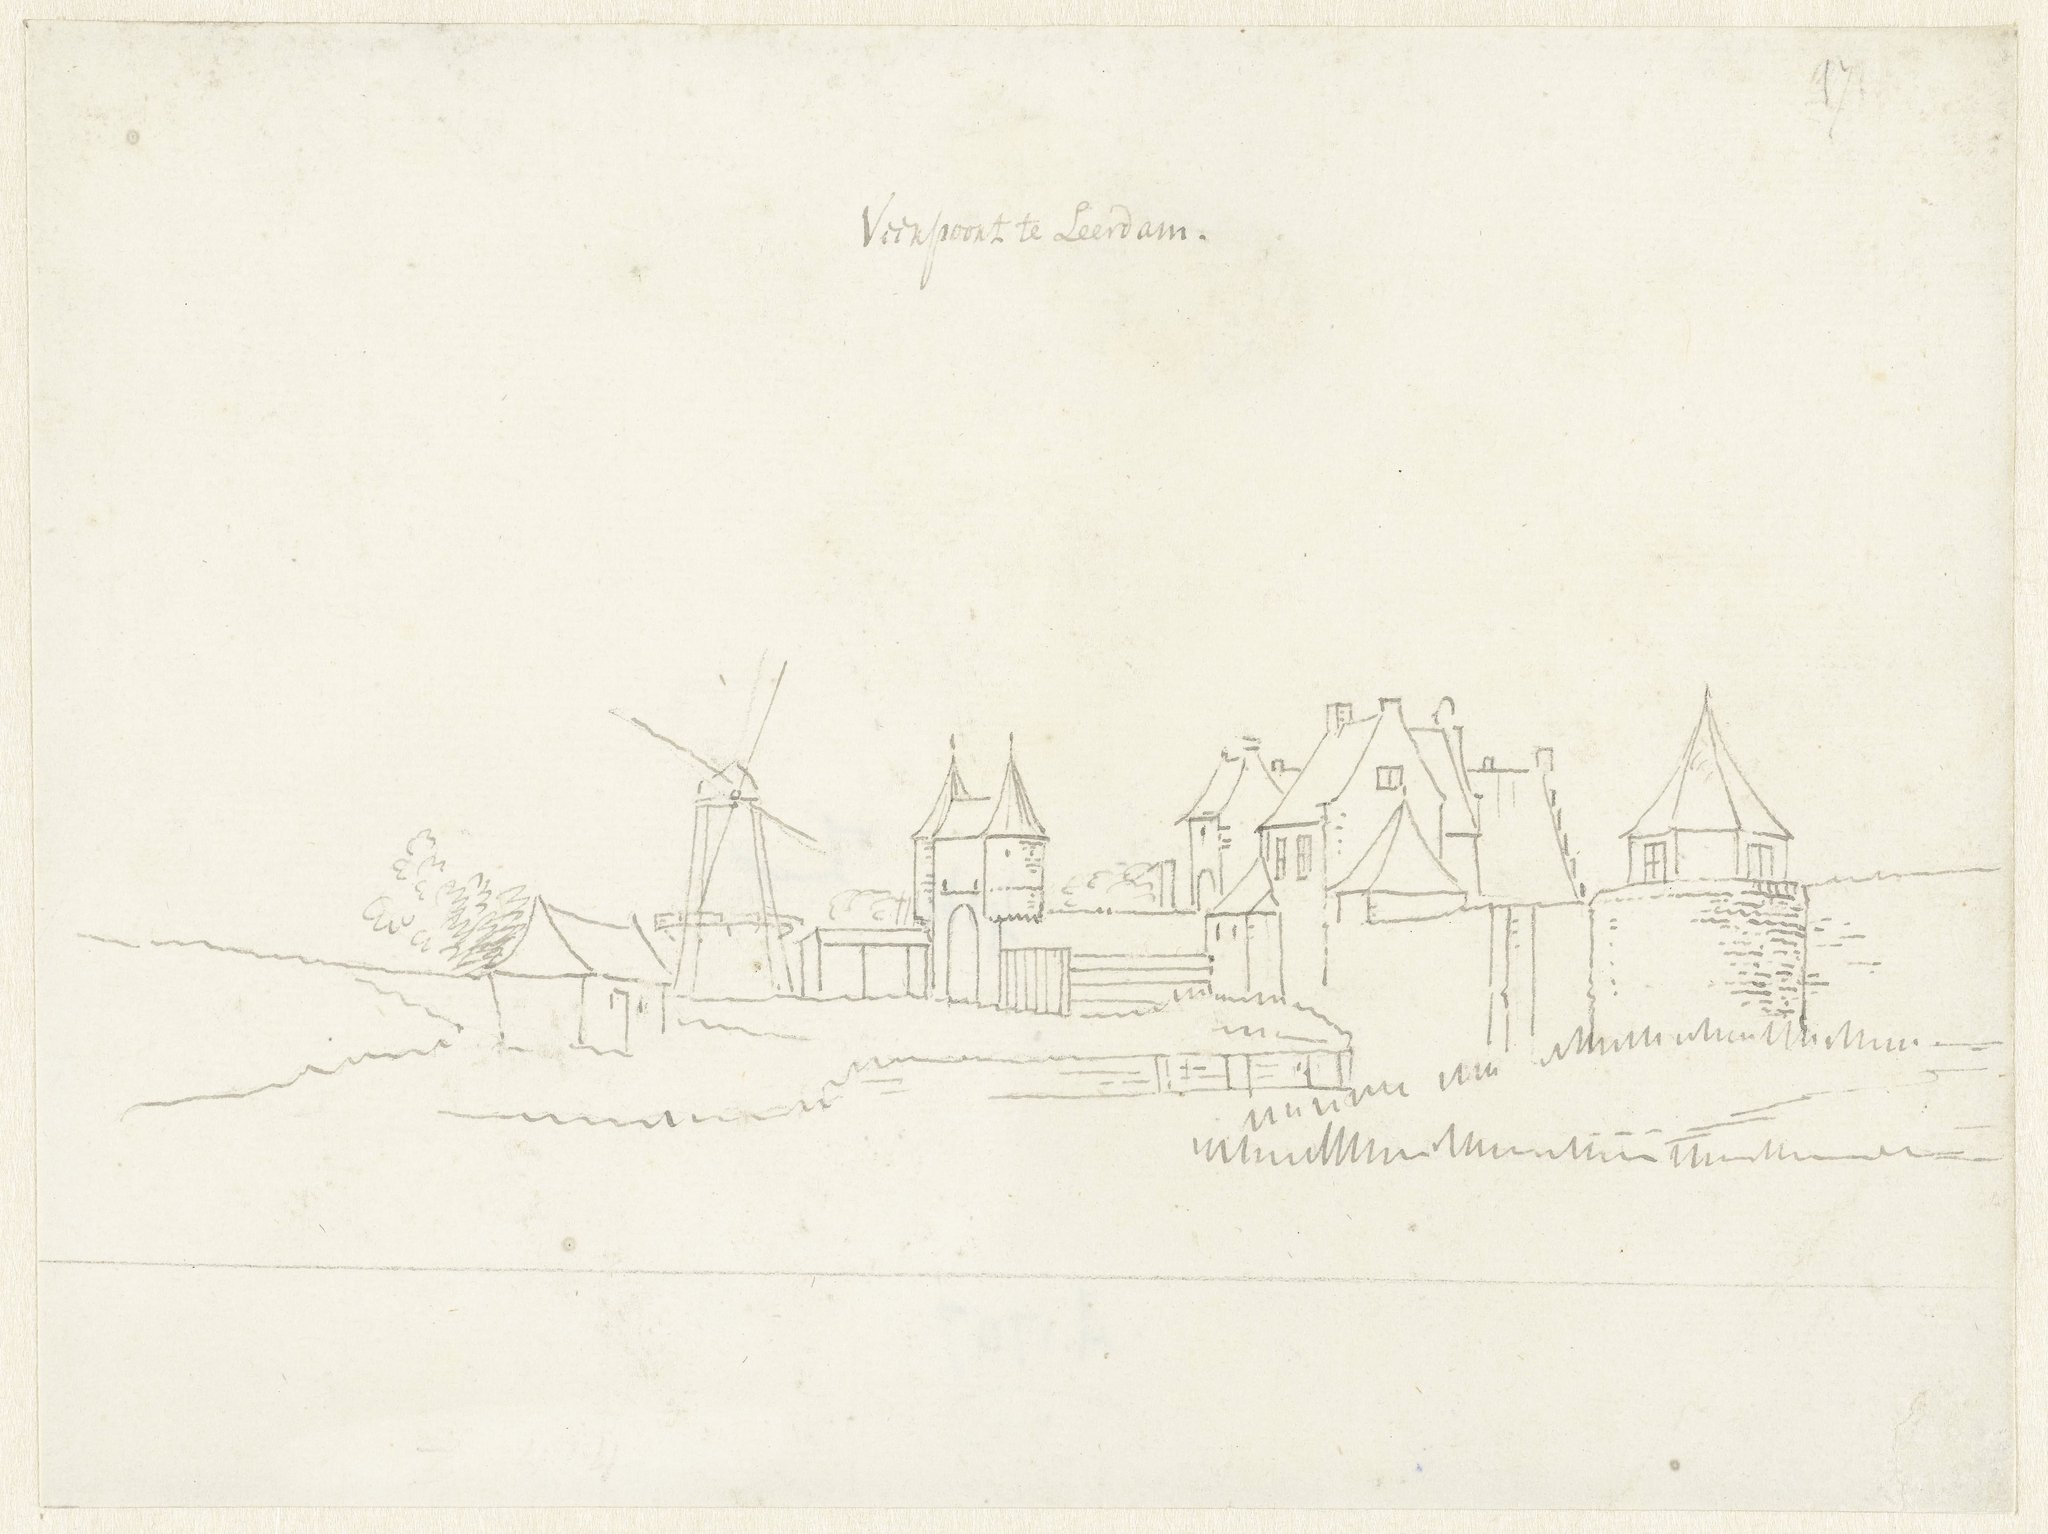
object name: drawing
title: Veerpoort te Leerdam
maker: cornelis pronk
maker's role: draughtsman, painter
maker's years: 1691-1759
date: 1701-1759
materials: ink, paper, pencil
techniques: pen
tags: windmill, city-gate, prospect of city, town panorama, silhouette of city